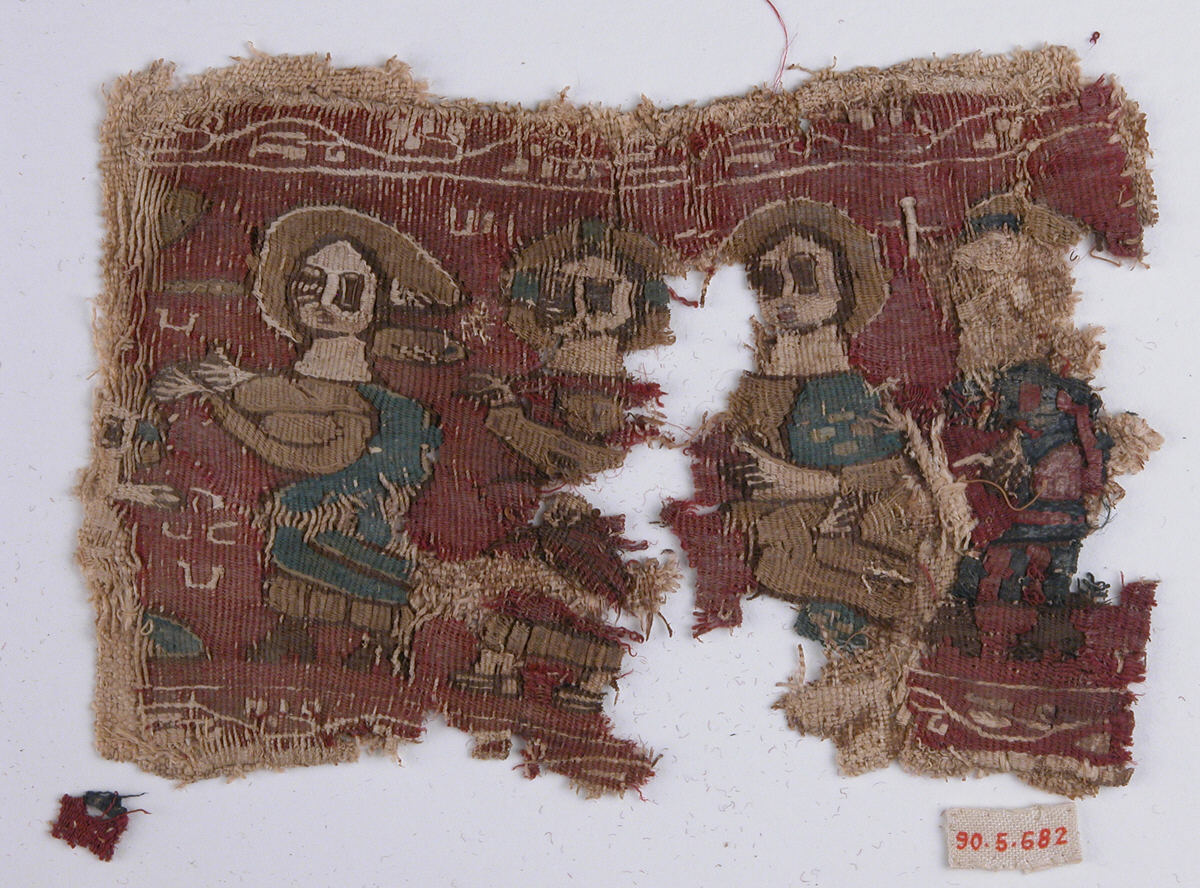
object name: textile fragment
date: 601-800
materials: linen, wool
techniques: weave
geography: egypt